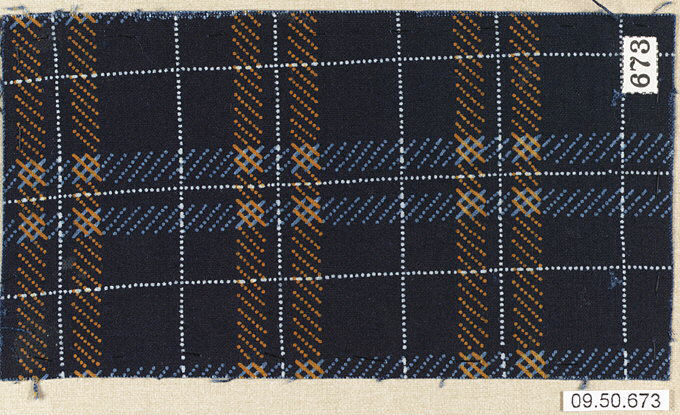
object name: piece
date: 1801-1900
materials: cotton